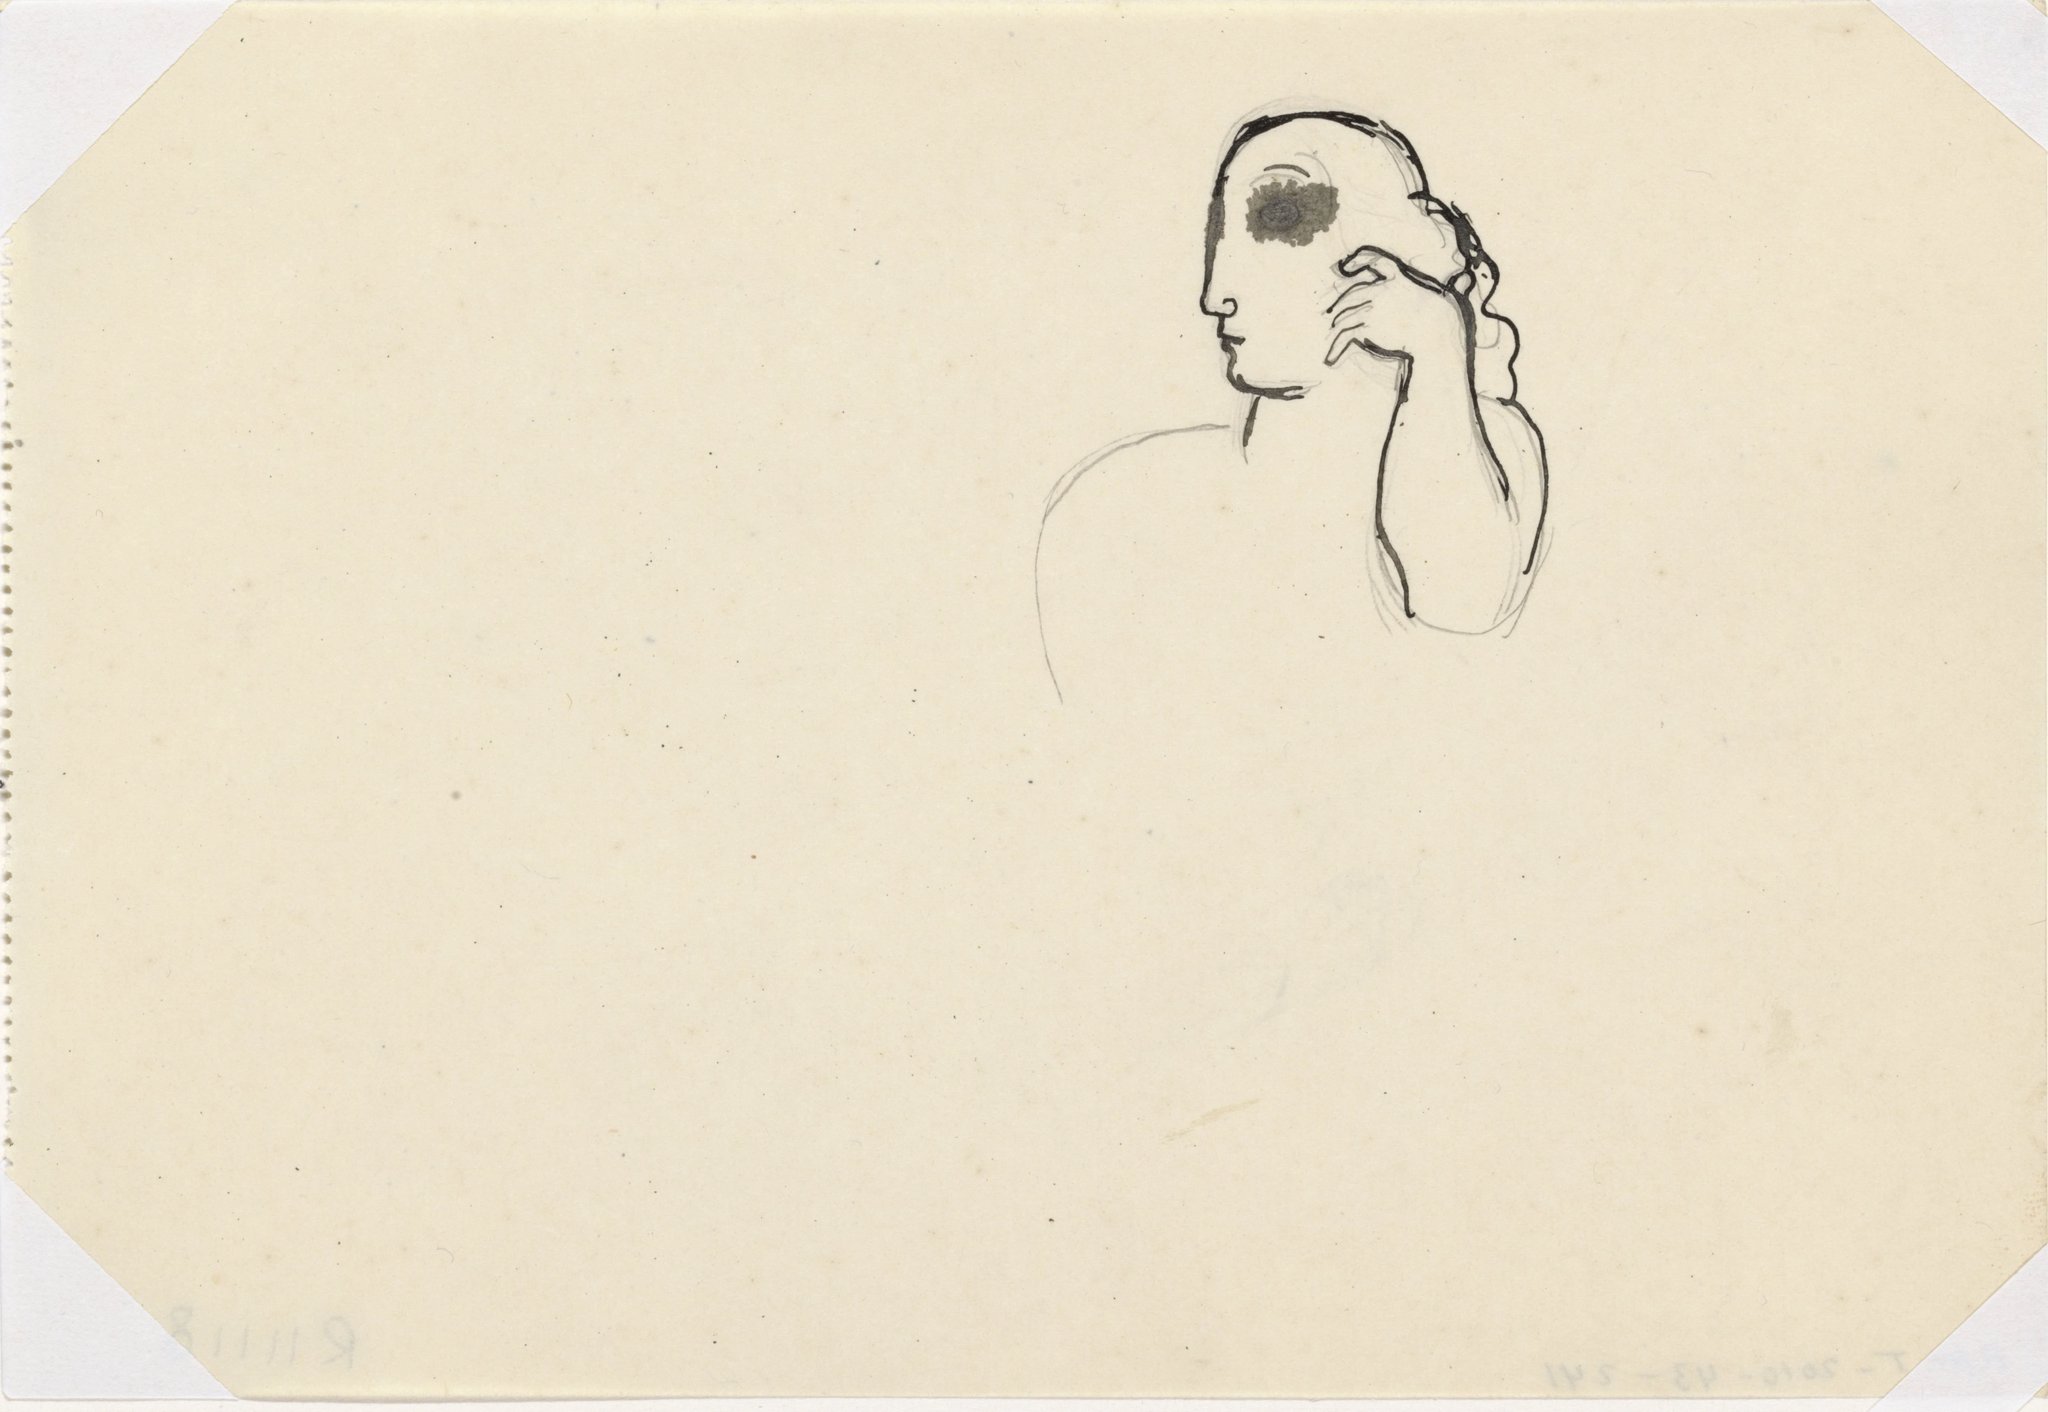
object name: drawing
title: Zonder titel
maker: leo gestel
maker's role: draughtsman, print maker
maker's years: 1881-1941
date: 1932-1933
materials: ink, paper, pencil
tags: taking a bath, sitting figure - aa - female human figure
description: Detail van compositie met baadsters; slechts hoofd, schouder en hand bij slaap zichtbaar.